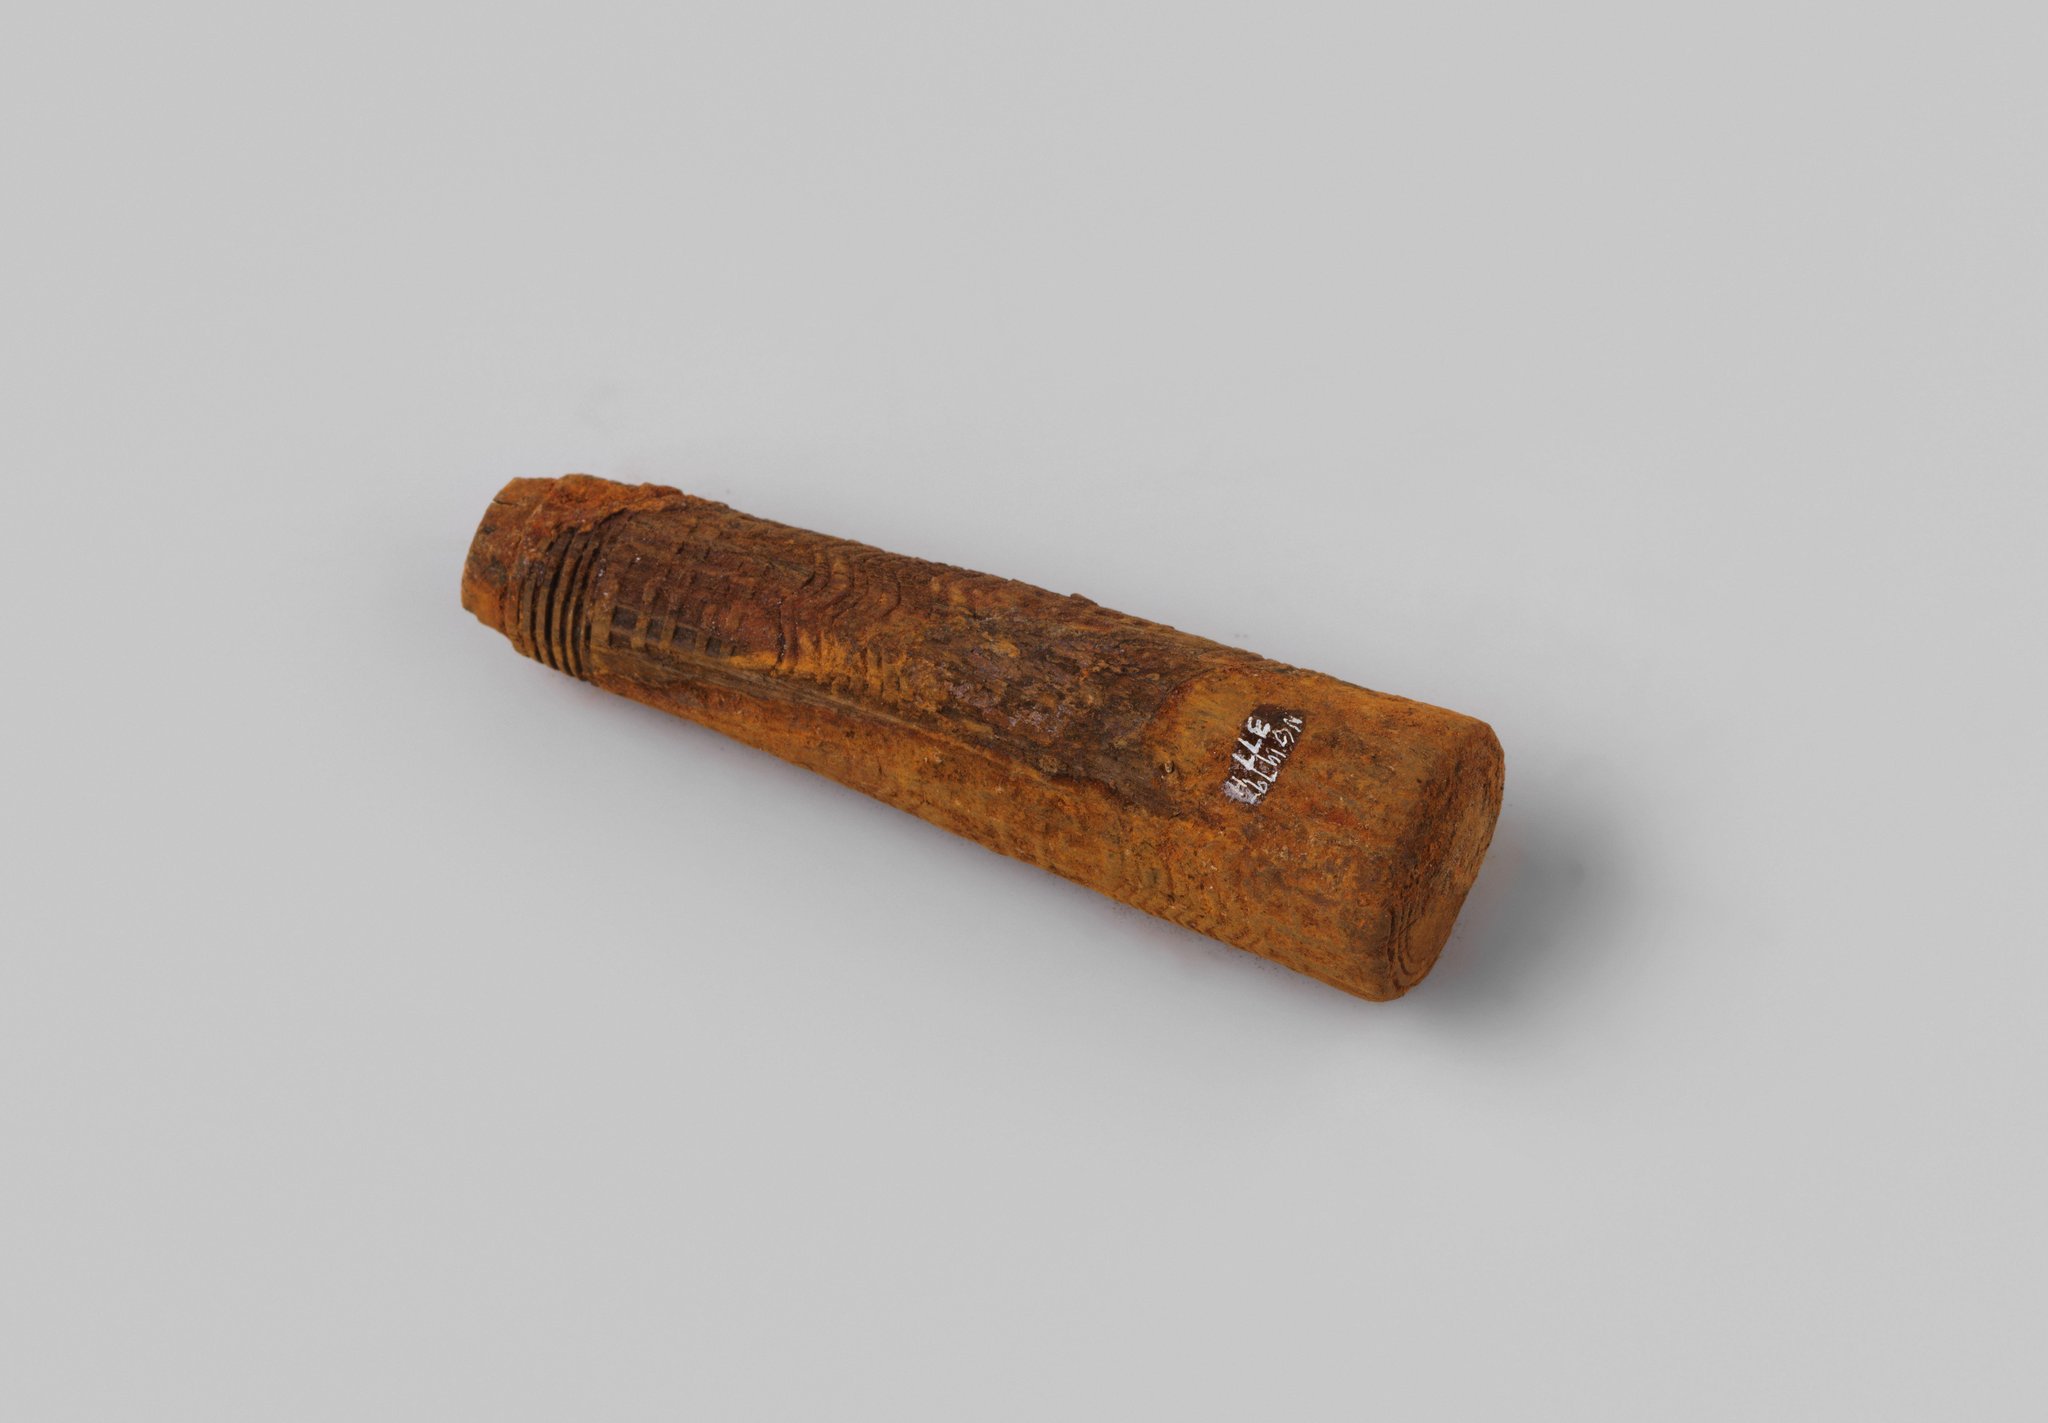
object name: knife handle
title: Messenheft uit het wrak van de Oost-Indiëvaarder Hollandia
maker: Anonymous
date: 1700-1743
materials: wood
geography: netherlands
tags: verenigde oostindische compagnie, hollandia (schip), annet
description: Knife, handle, cylindrical: tapering; id. NG 1979-403H, ferrules id. NG 1980-27H426.